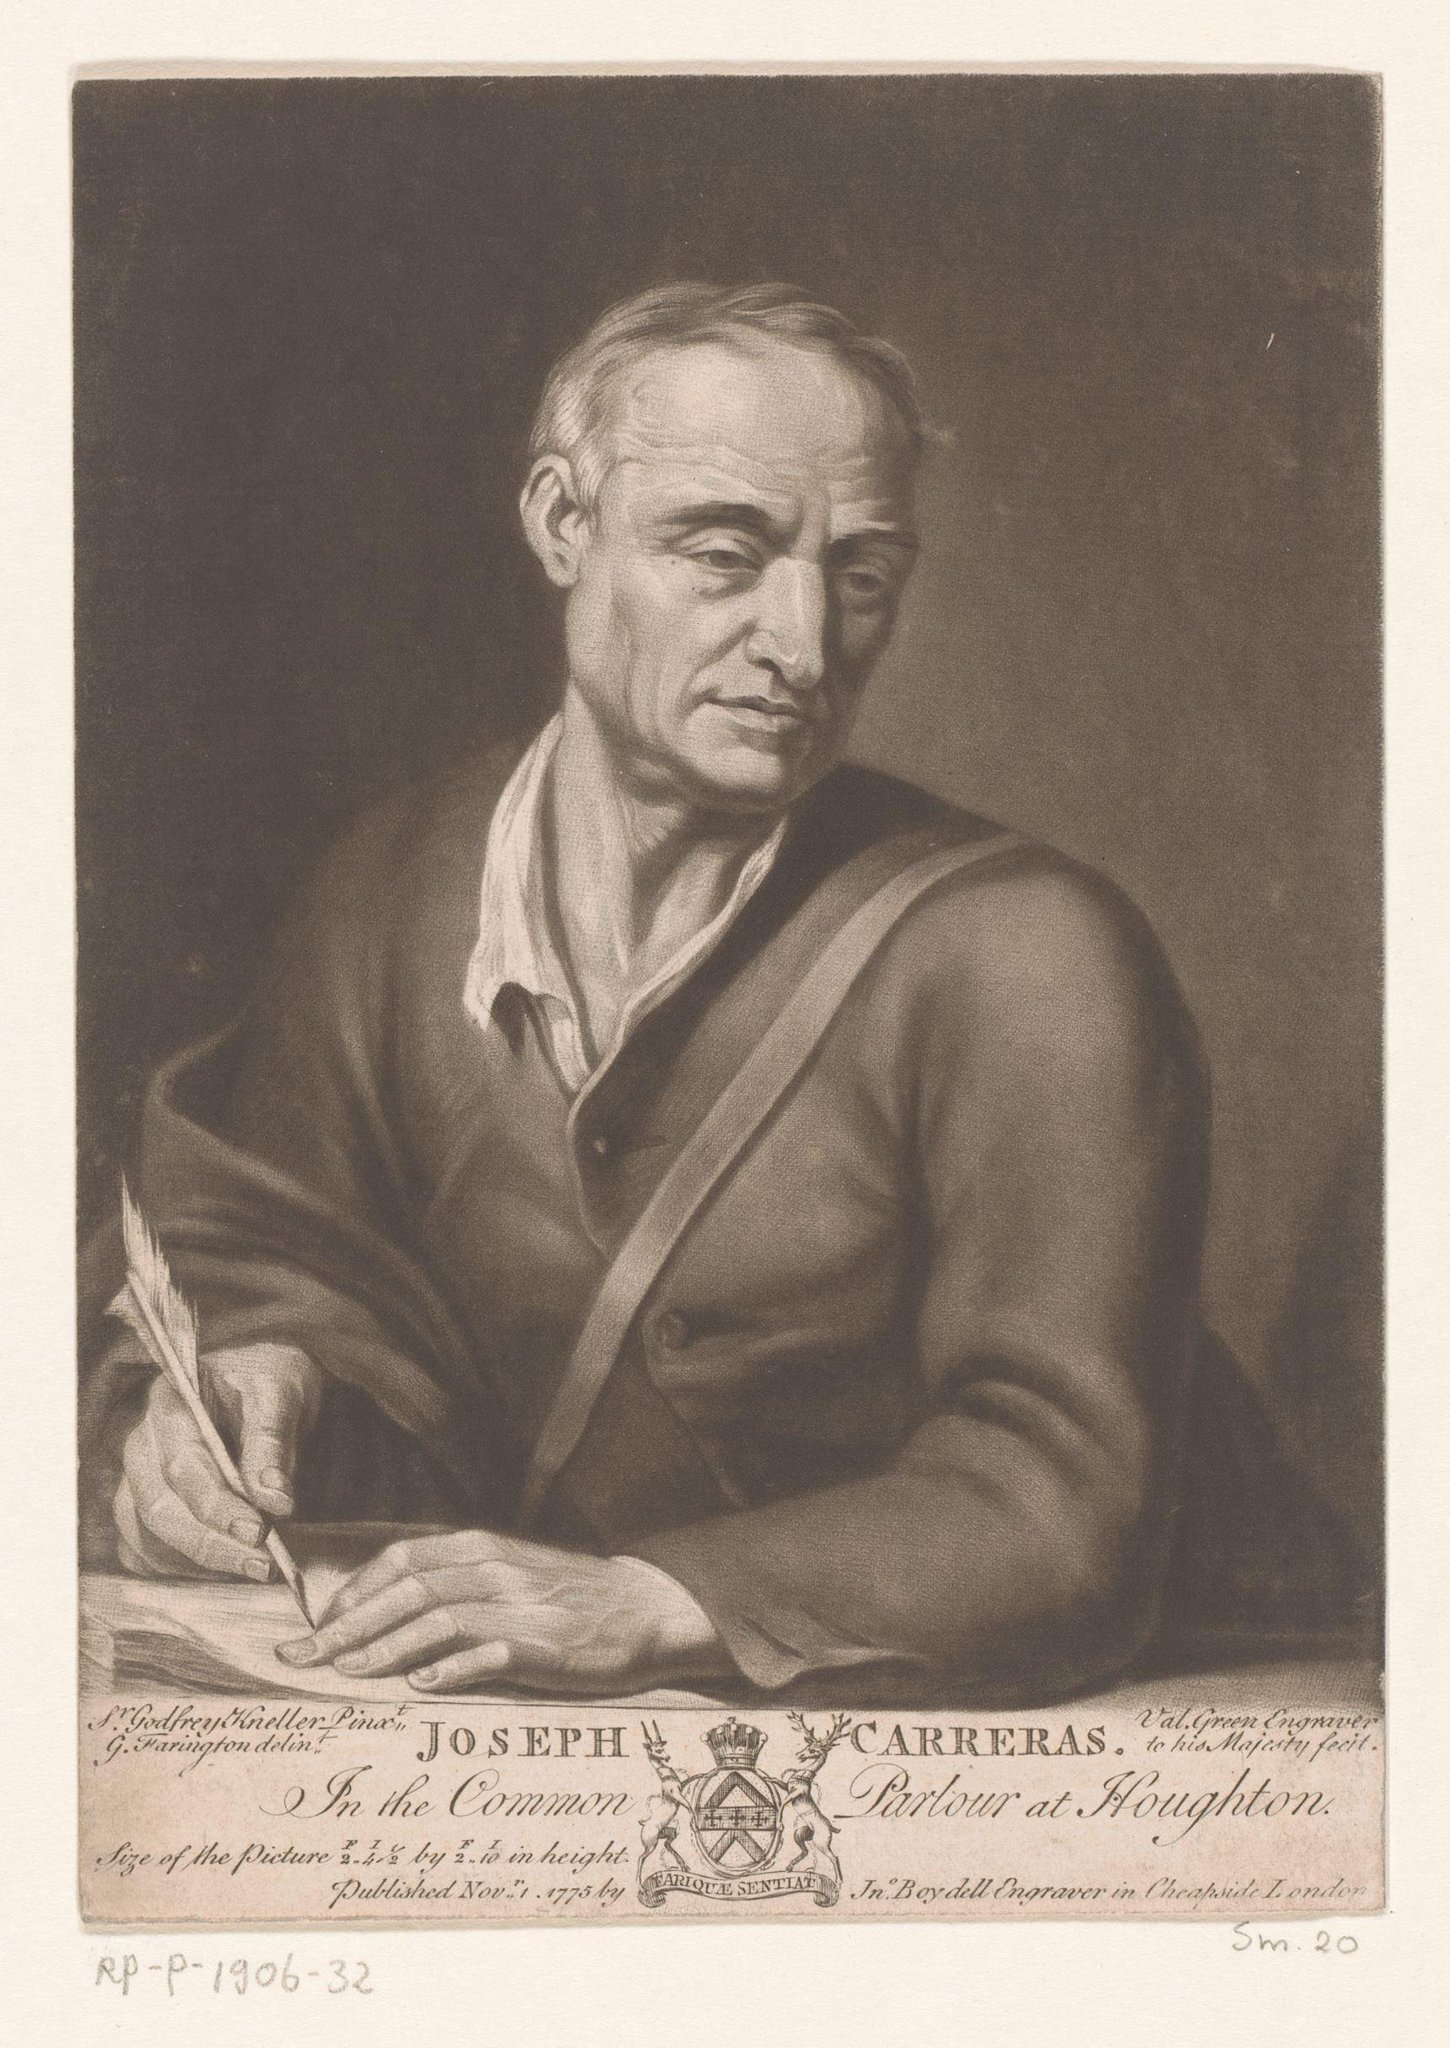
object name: print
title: Portret van Joseph Carreras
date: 1775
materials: paper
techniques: etching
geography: london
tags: historical persons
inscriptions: collector's mark: Lugt 2228